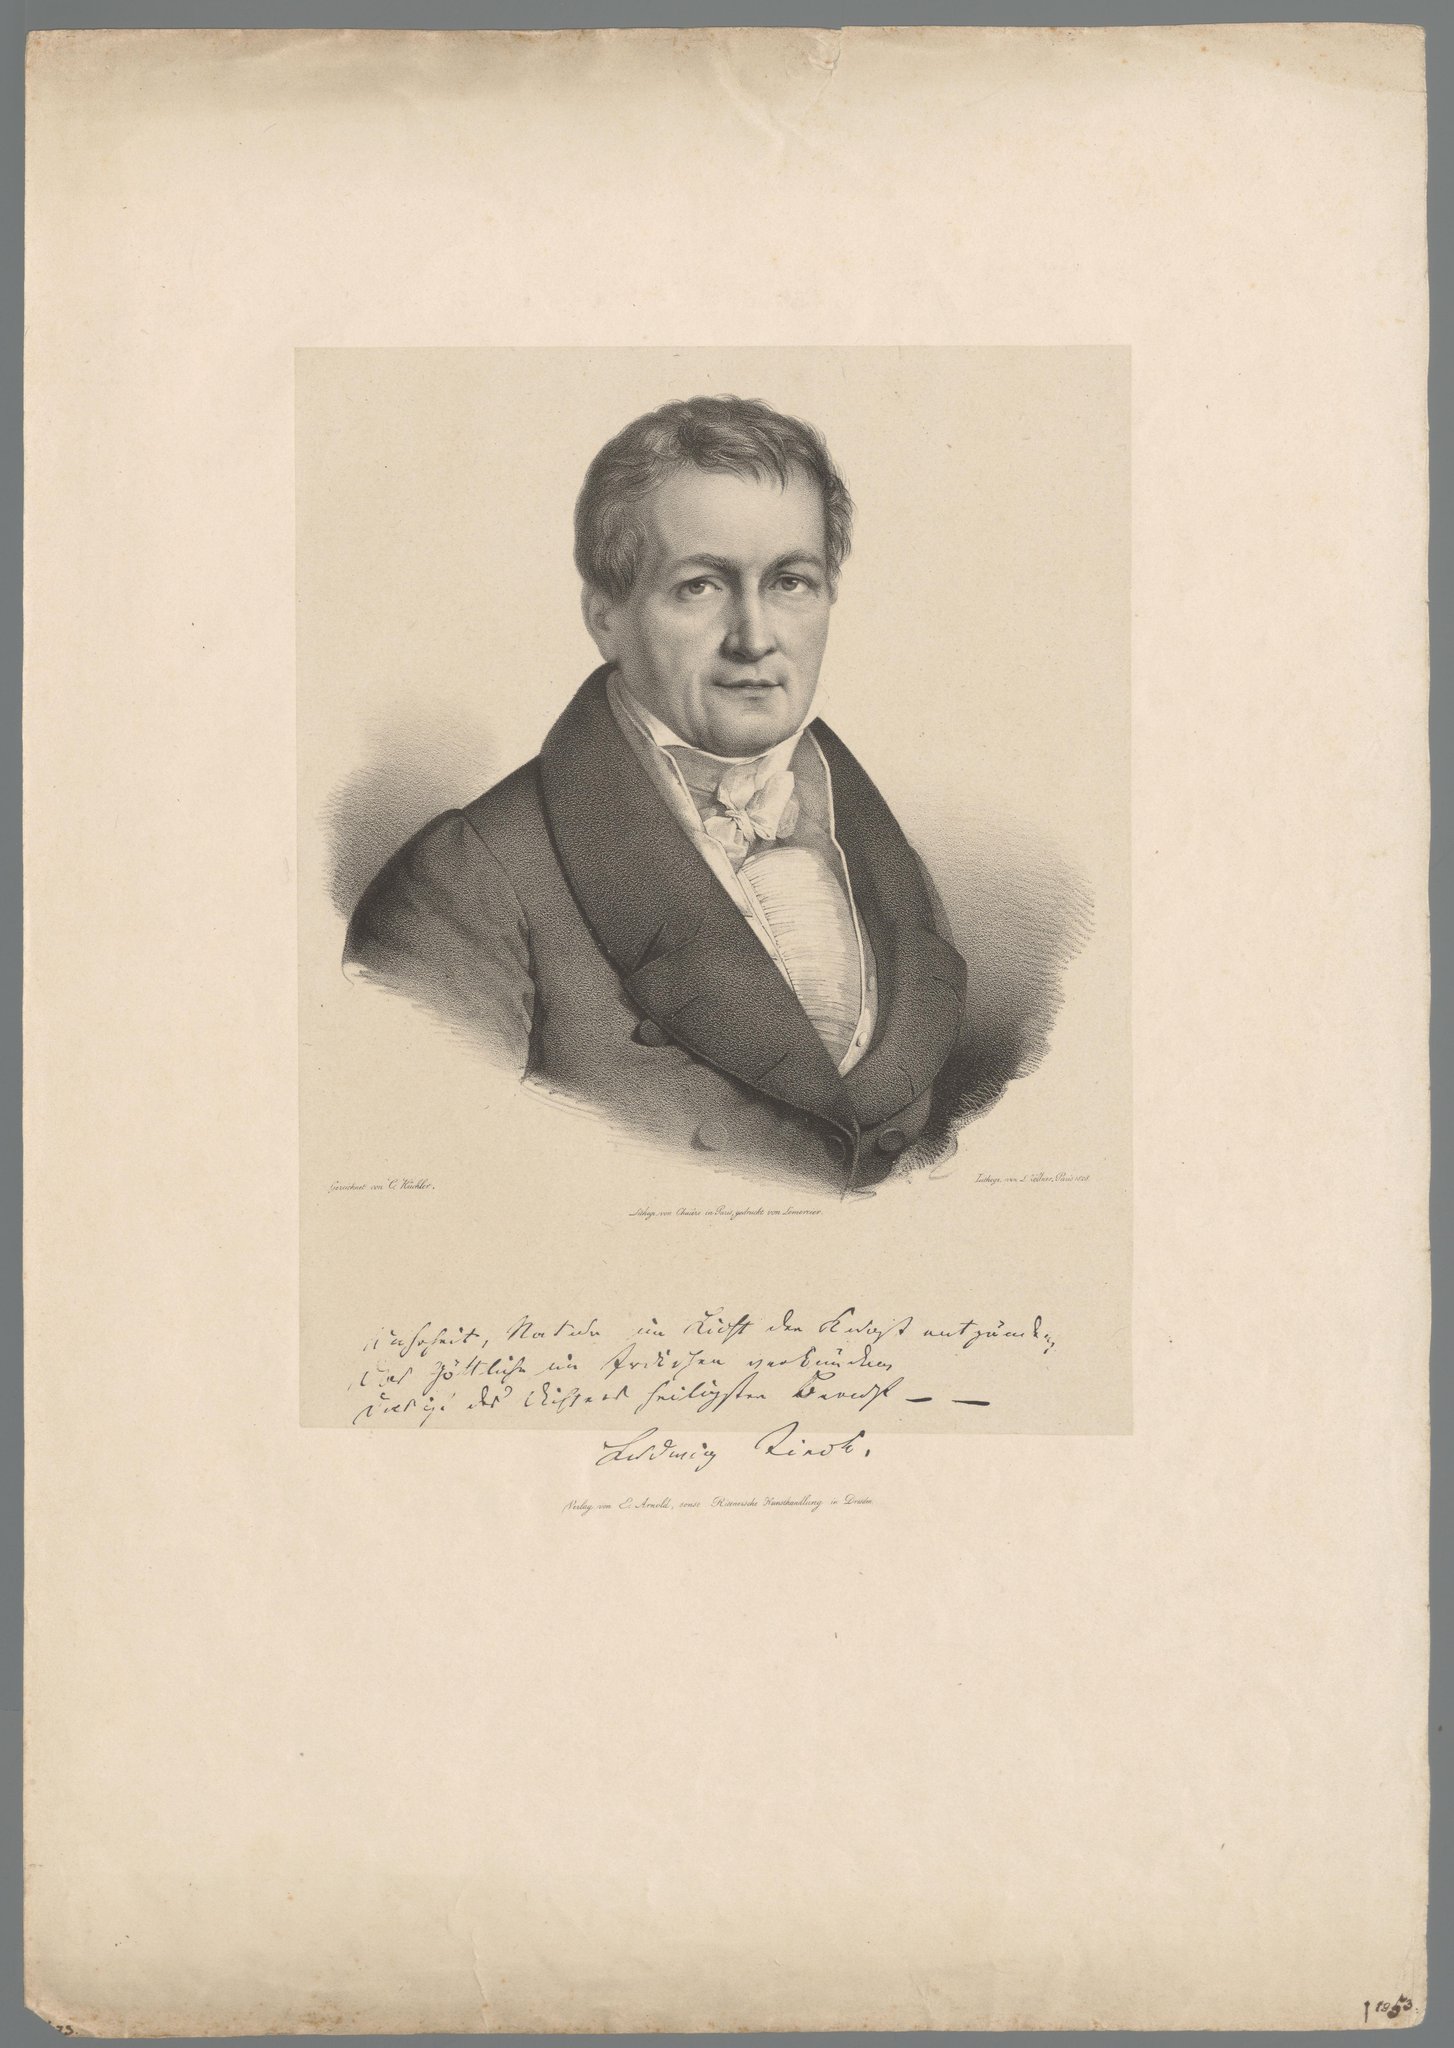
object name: print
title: Portret van Ludwig Tieck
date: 1828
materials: paper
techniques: lithograph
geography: dresden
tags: historical persons, portrait of a writer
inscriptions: collector's mark: Lugt 2228